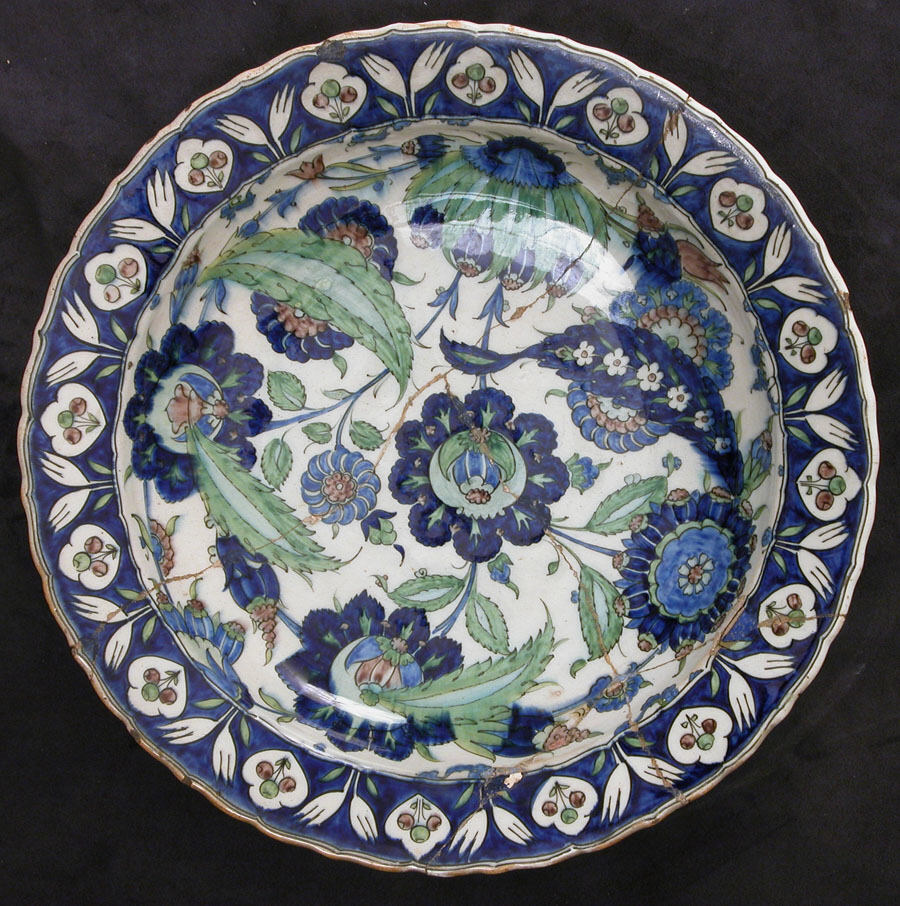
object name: dish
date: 1601-1700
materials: ceramic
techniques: painting, underglaze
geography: turkey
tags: flowers,leaves